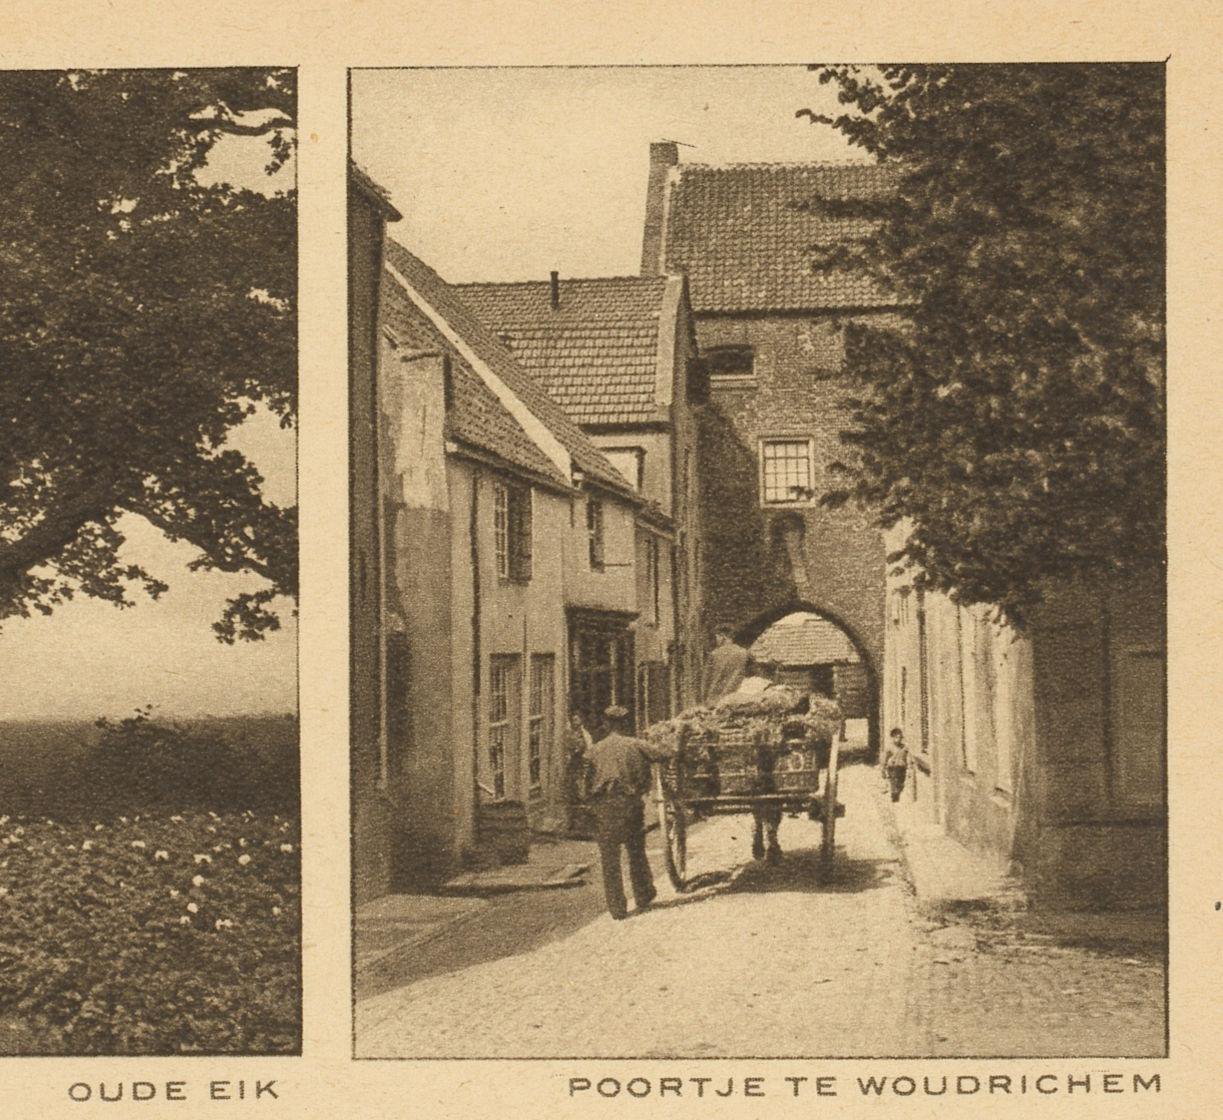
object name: album leaf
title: Poortje te Woudrichem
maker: Anonymous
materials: paper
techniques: rotogravure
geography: woudrichem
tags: gate ~ fortified city, street (+ city(-scape) with figures, staffage), woudrichem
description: Deze prent maakt deel uit van een album.